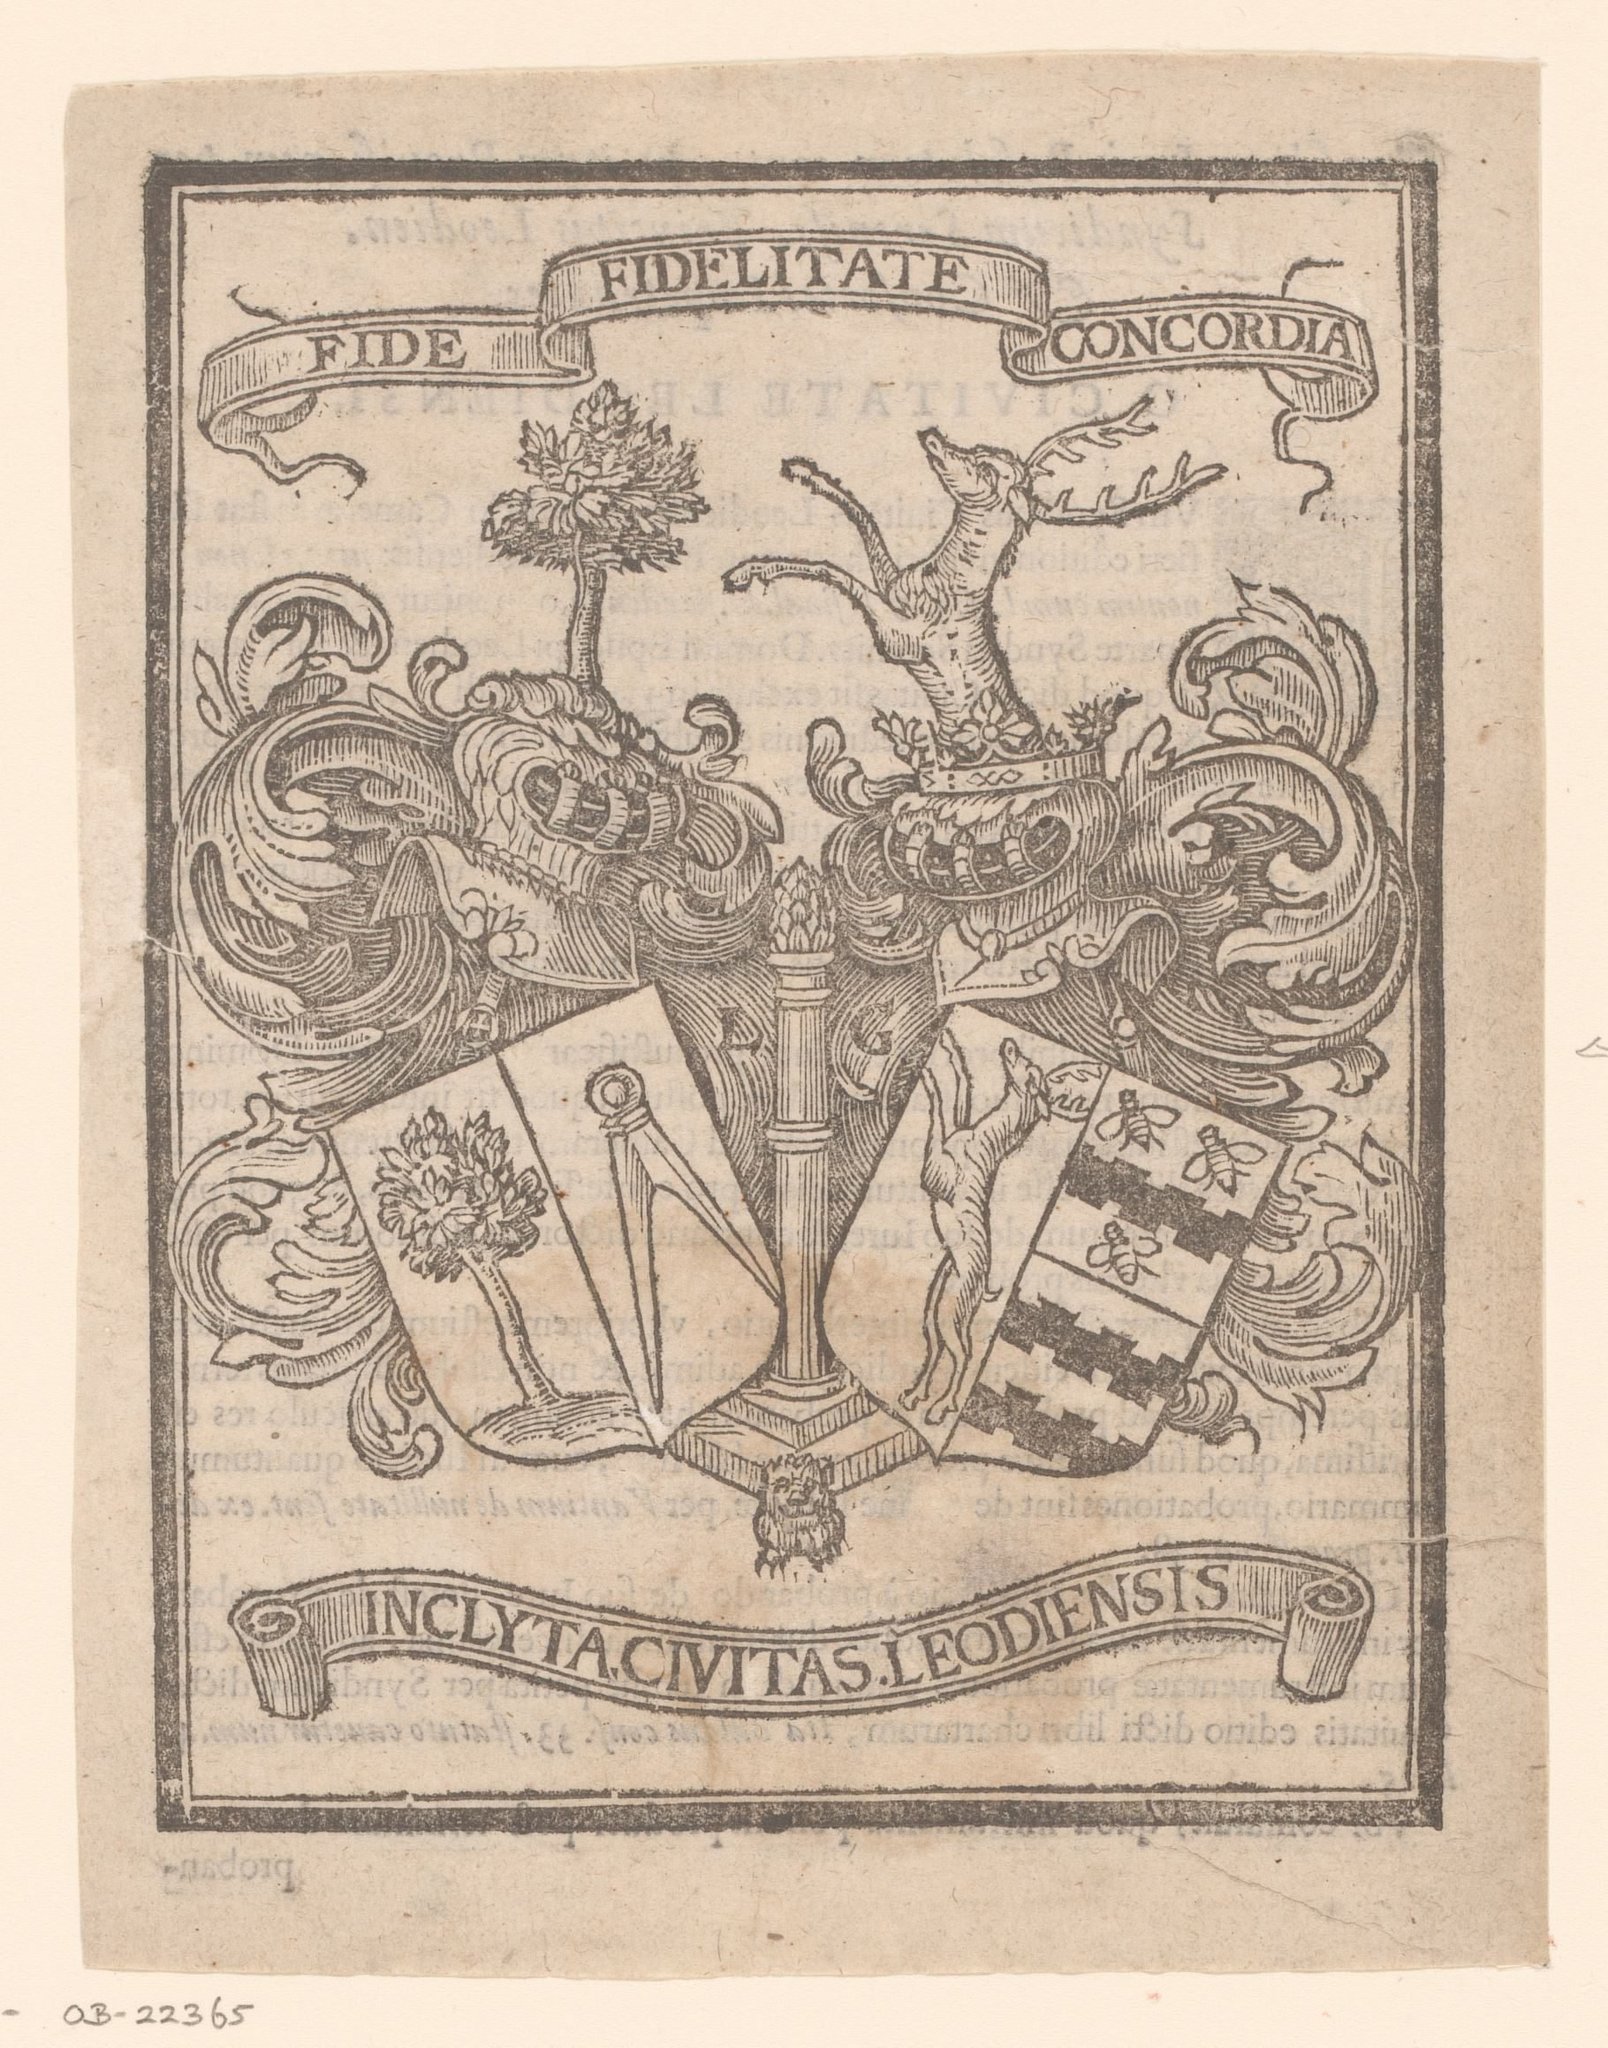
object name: print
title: Wapenschilden met familiewapens en stadswapen van Luik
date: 1500-1599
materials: paper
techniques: woodcut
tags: armorial bearing, heraldry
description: Persoen met aanweerzijden LG is stadswapen Luik.